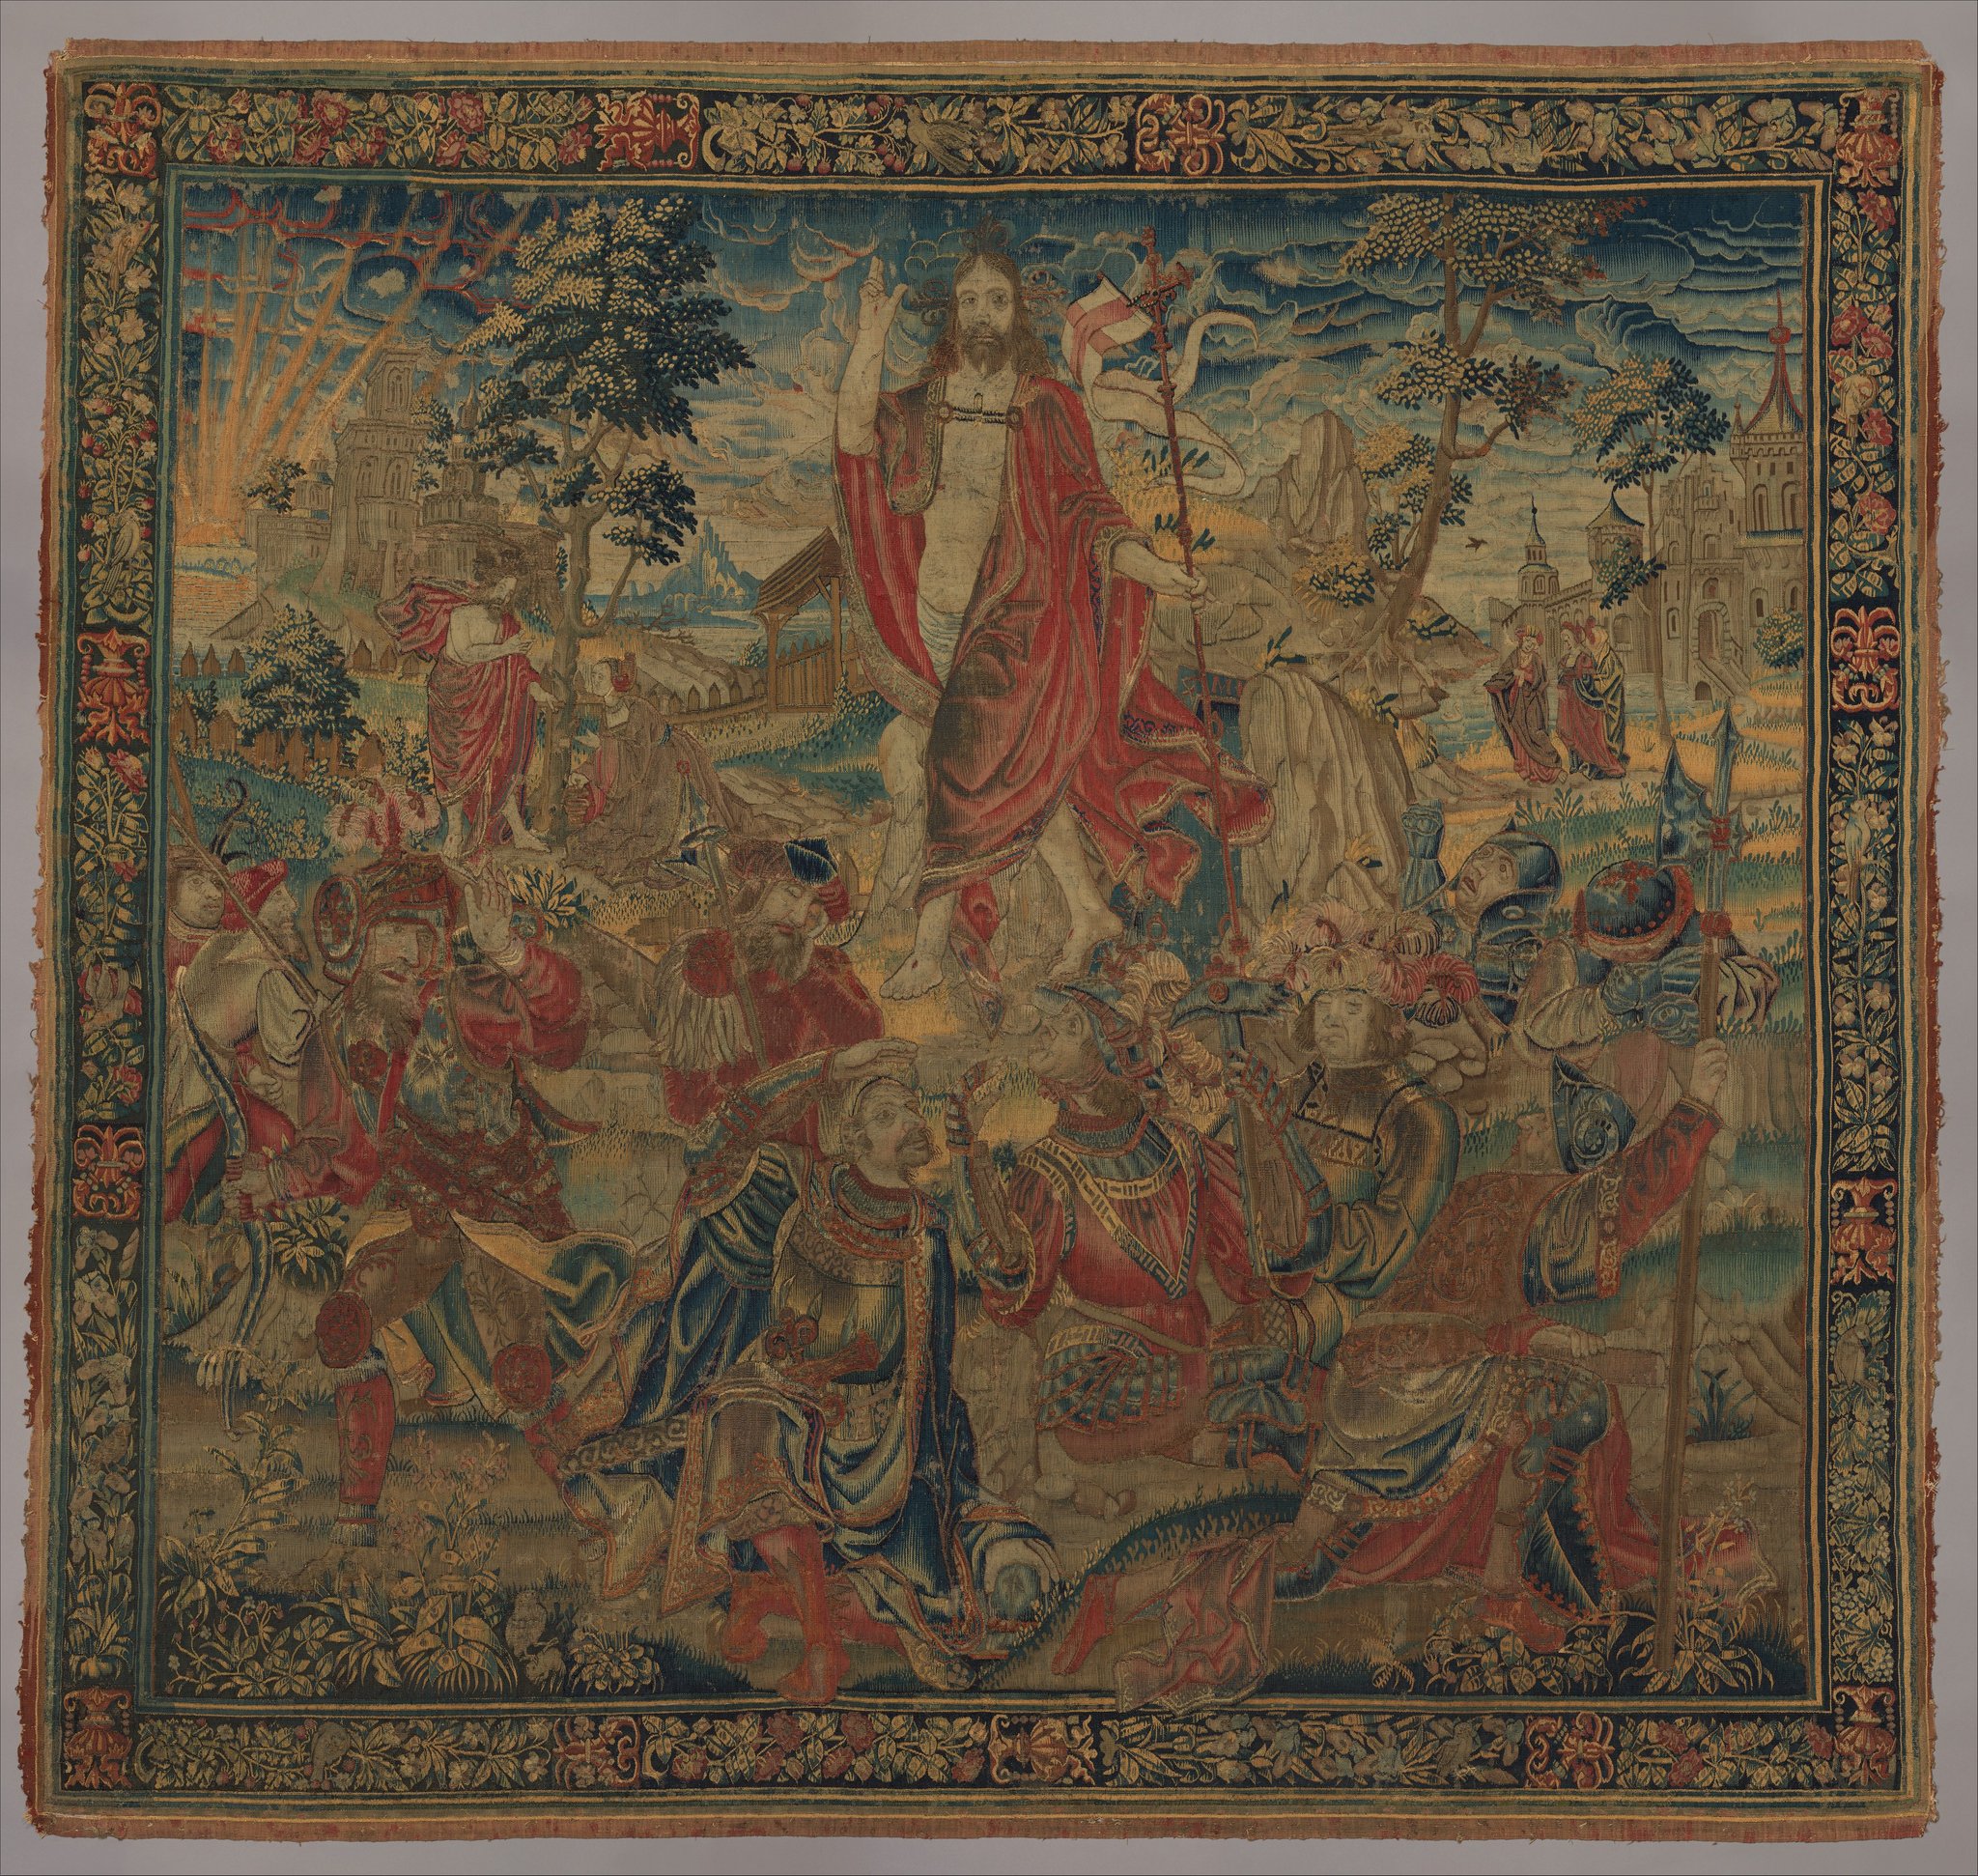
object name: tapestry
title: The Resurrection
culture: south netherlandish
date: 1515-1525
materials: gilt, silk, silver, wool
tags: men,christ